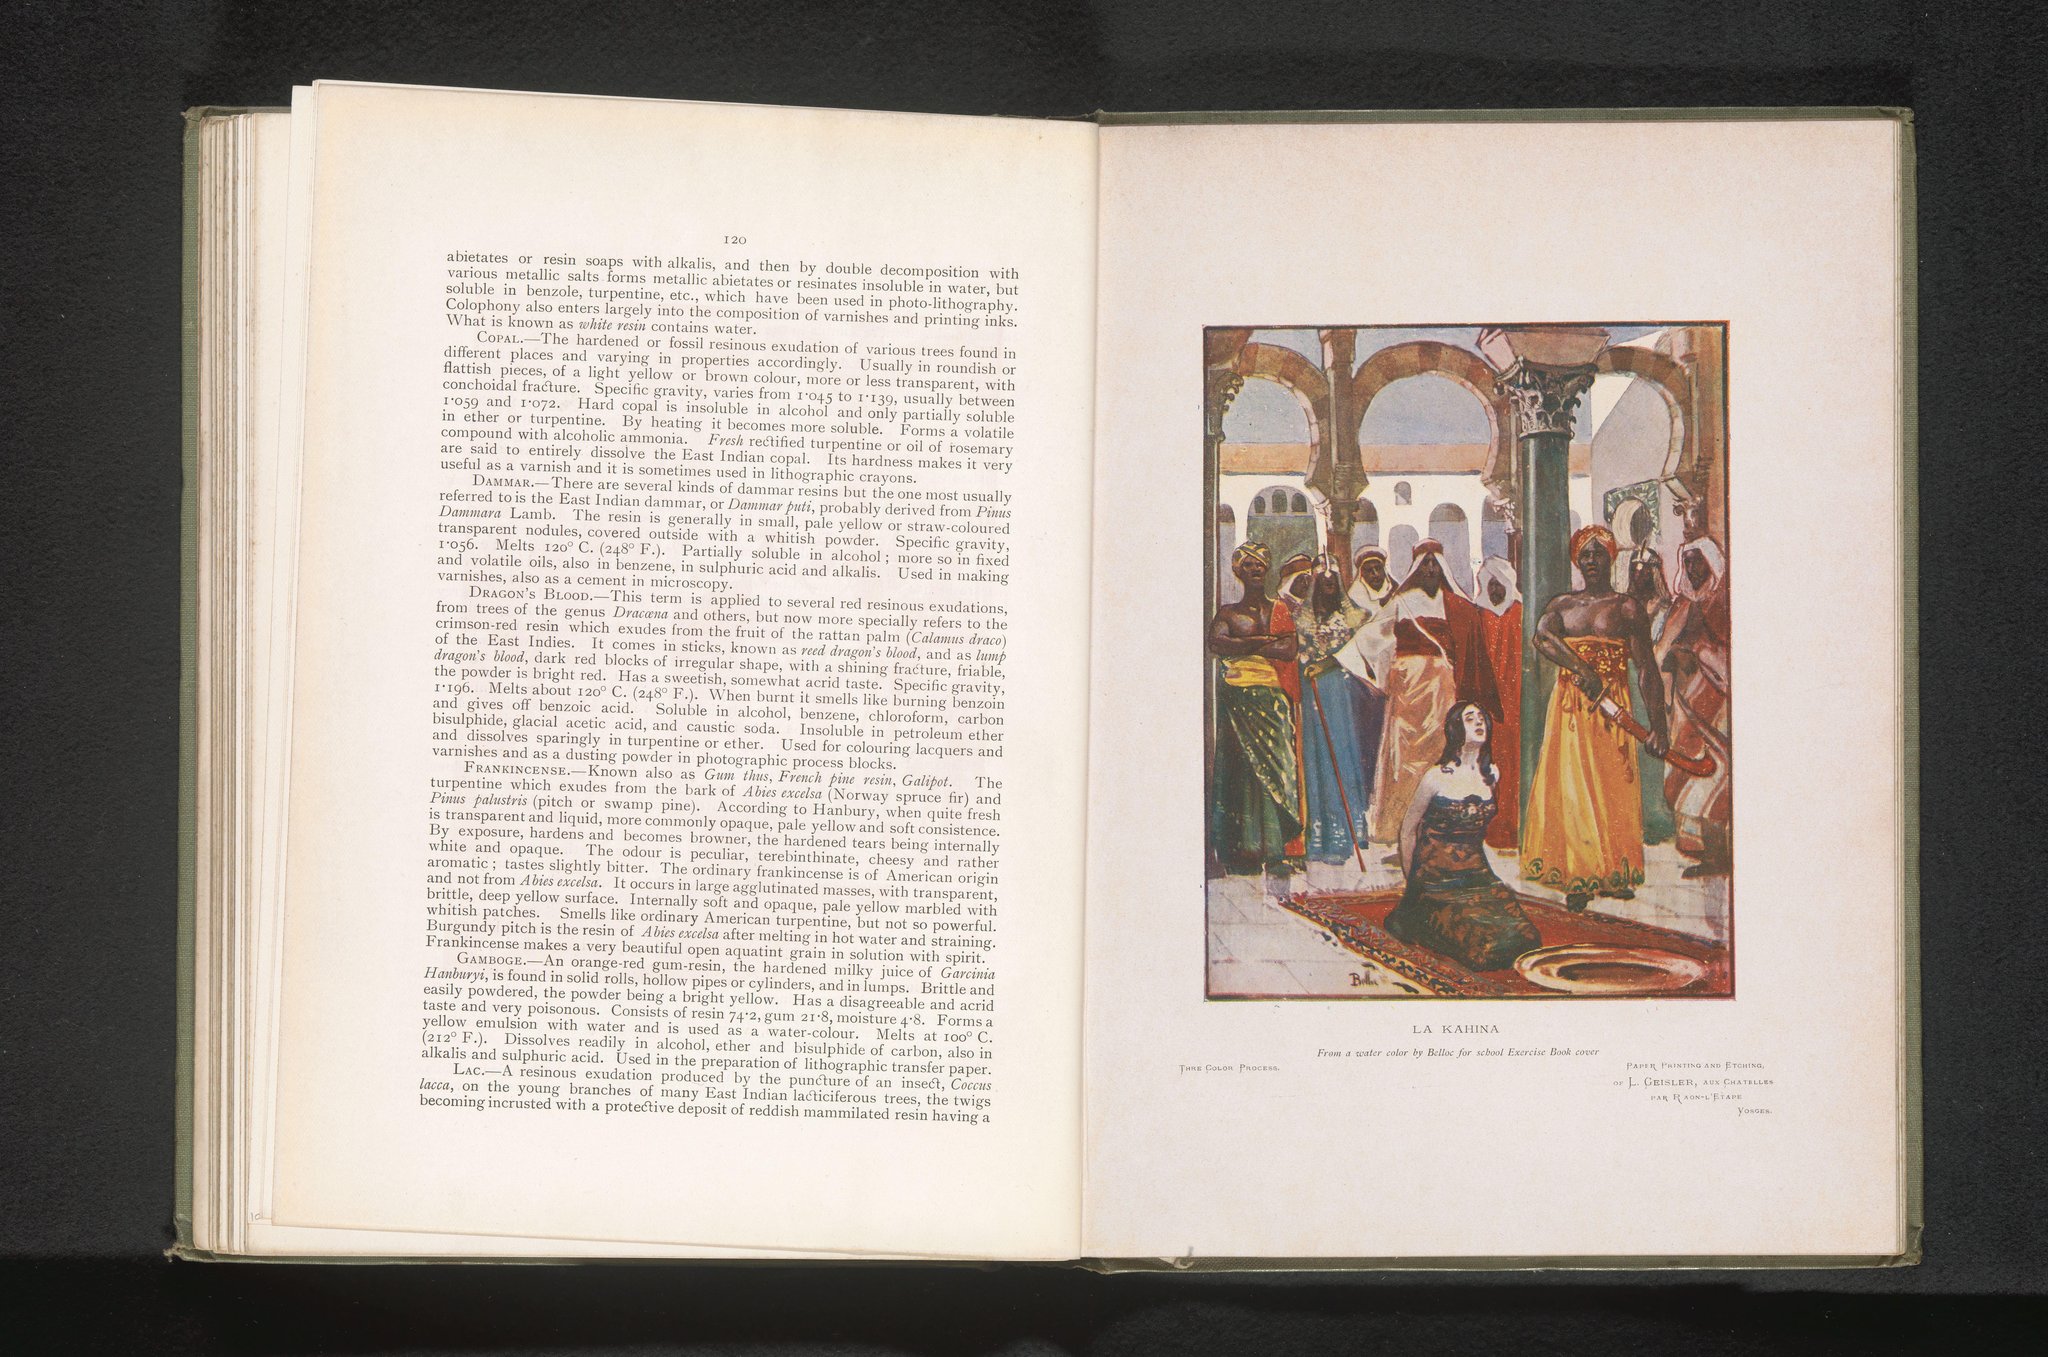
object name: page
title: La Kahina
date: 1893-1898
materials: paper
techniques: three-color autotype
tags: witch, sorceress